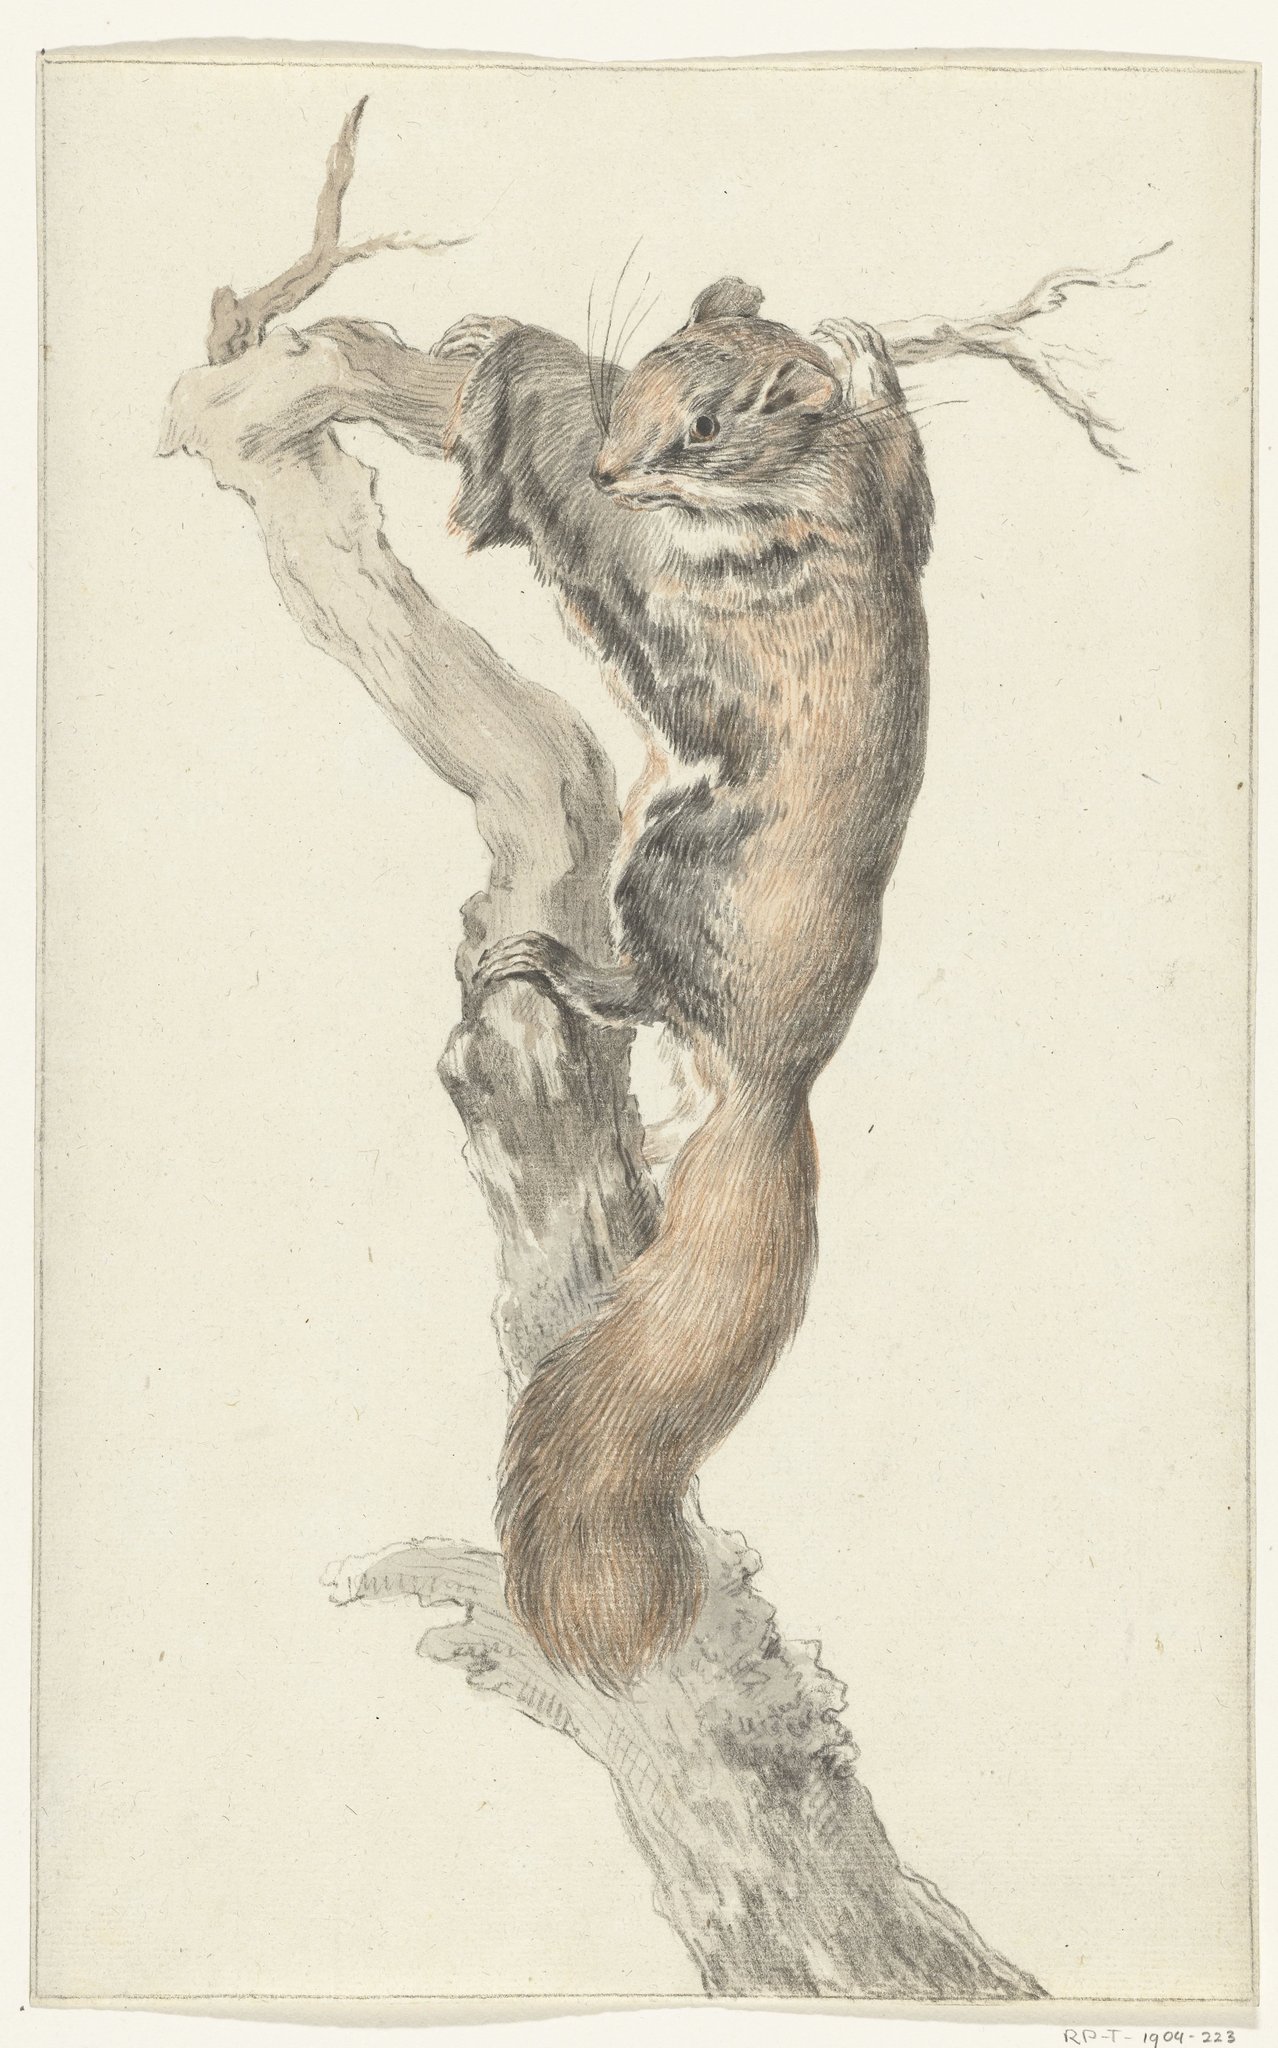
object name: drawing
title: Vliegende eekhoorn, op een tak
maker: jean bernard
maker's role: draughtsman, print maker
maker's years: 1765-1833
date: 1775-1833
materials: chalk, paper, pencil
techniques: brush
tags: rodents: flying squirrel